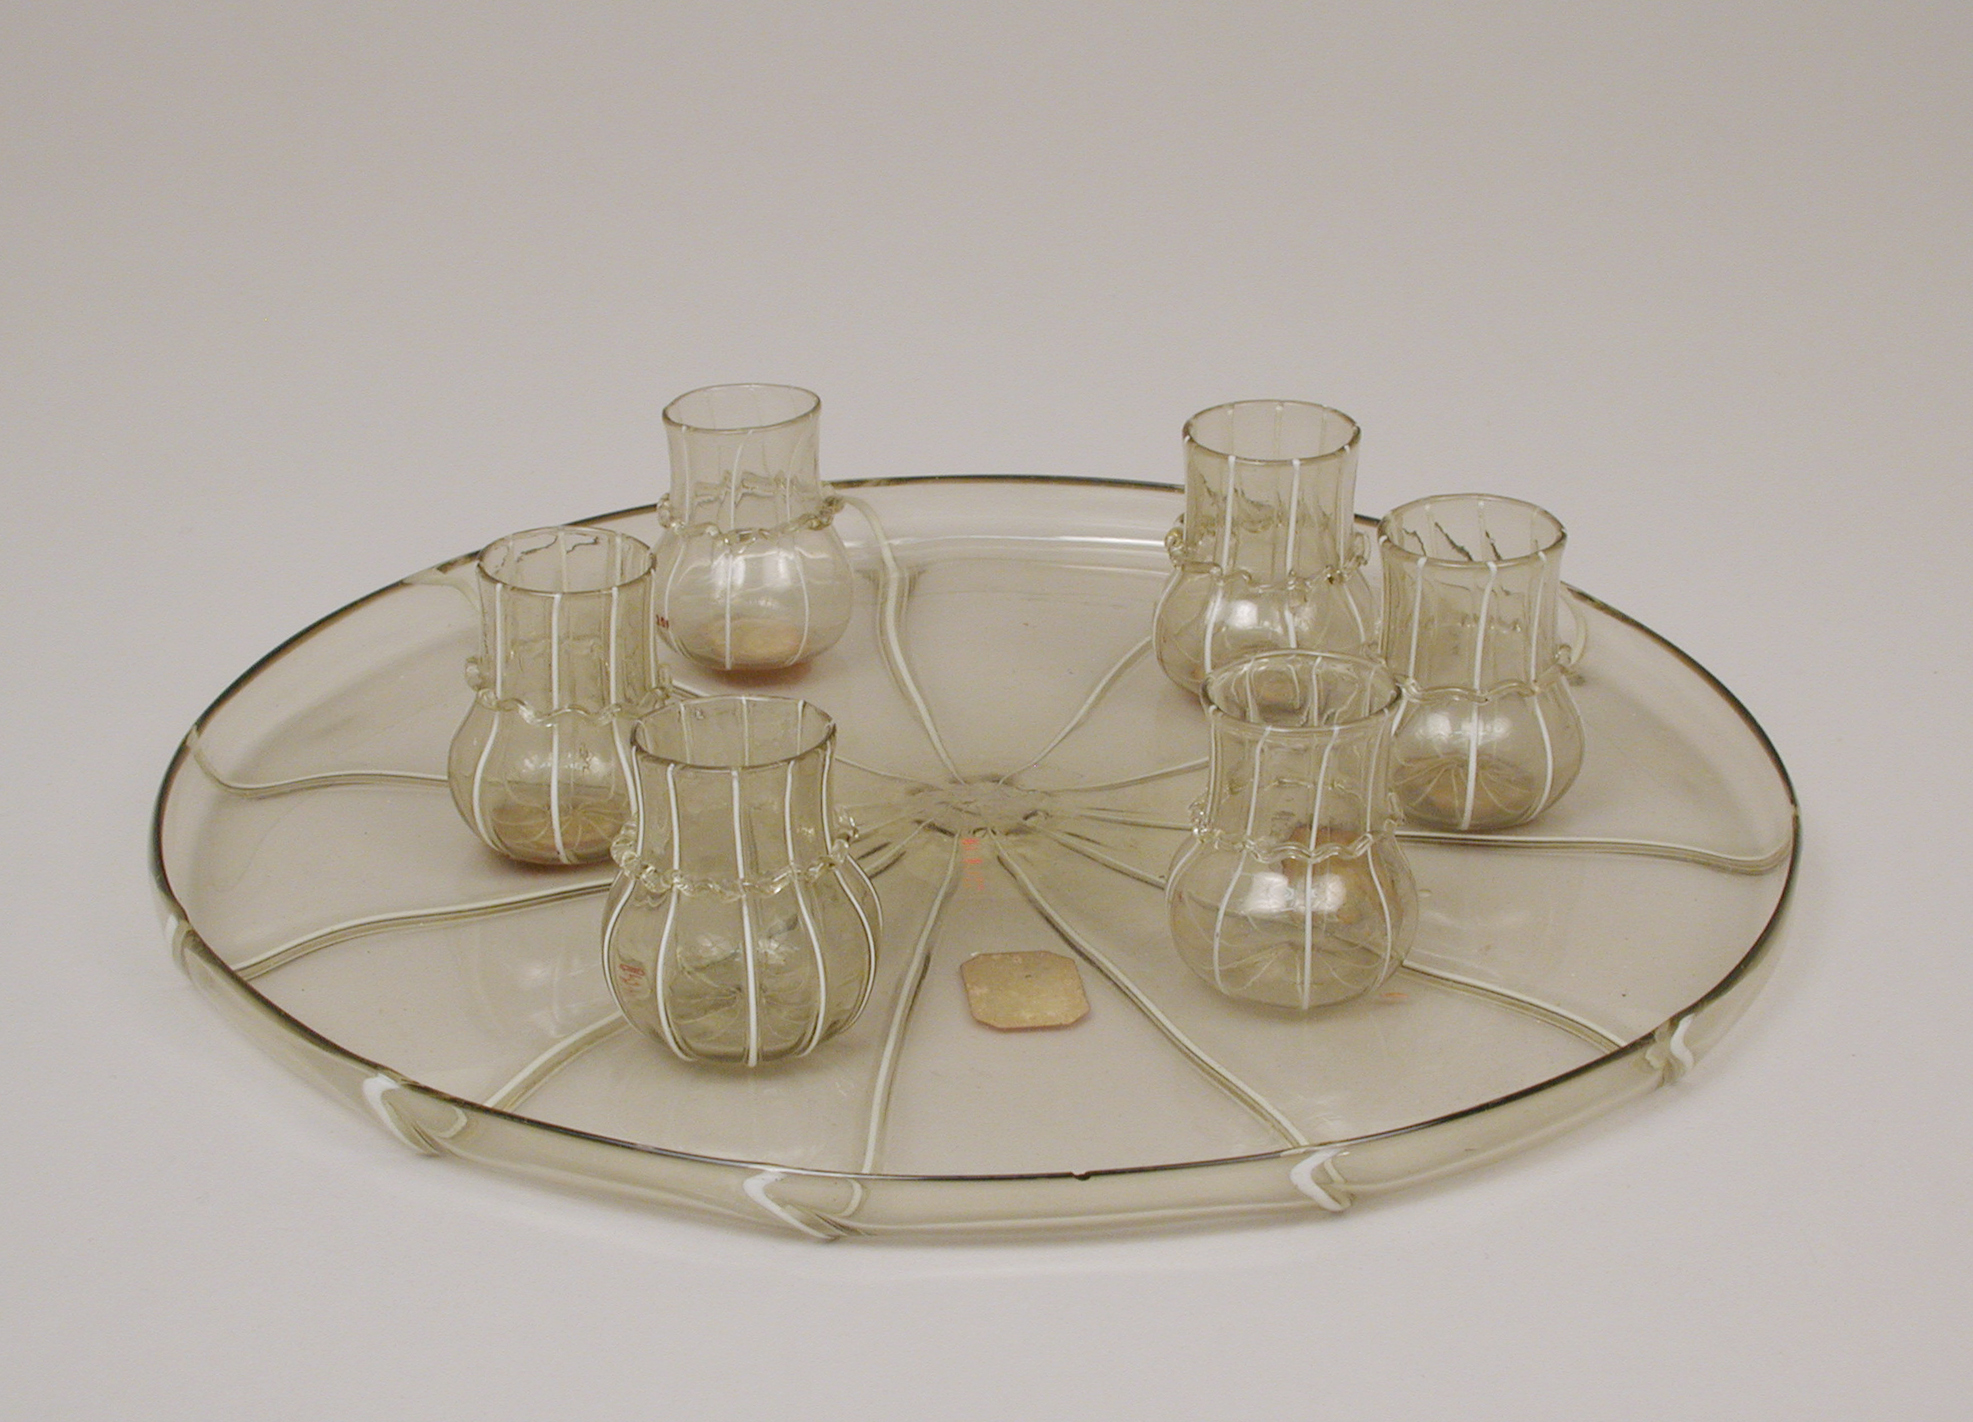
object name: schnapps glass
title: Schnapps glass (one of six)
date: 1801-1900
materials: glass